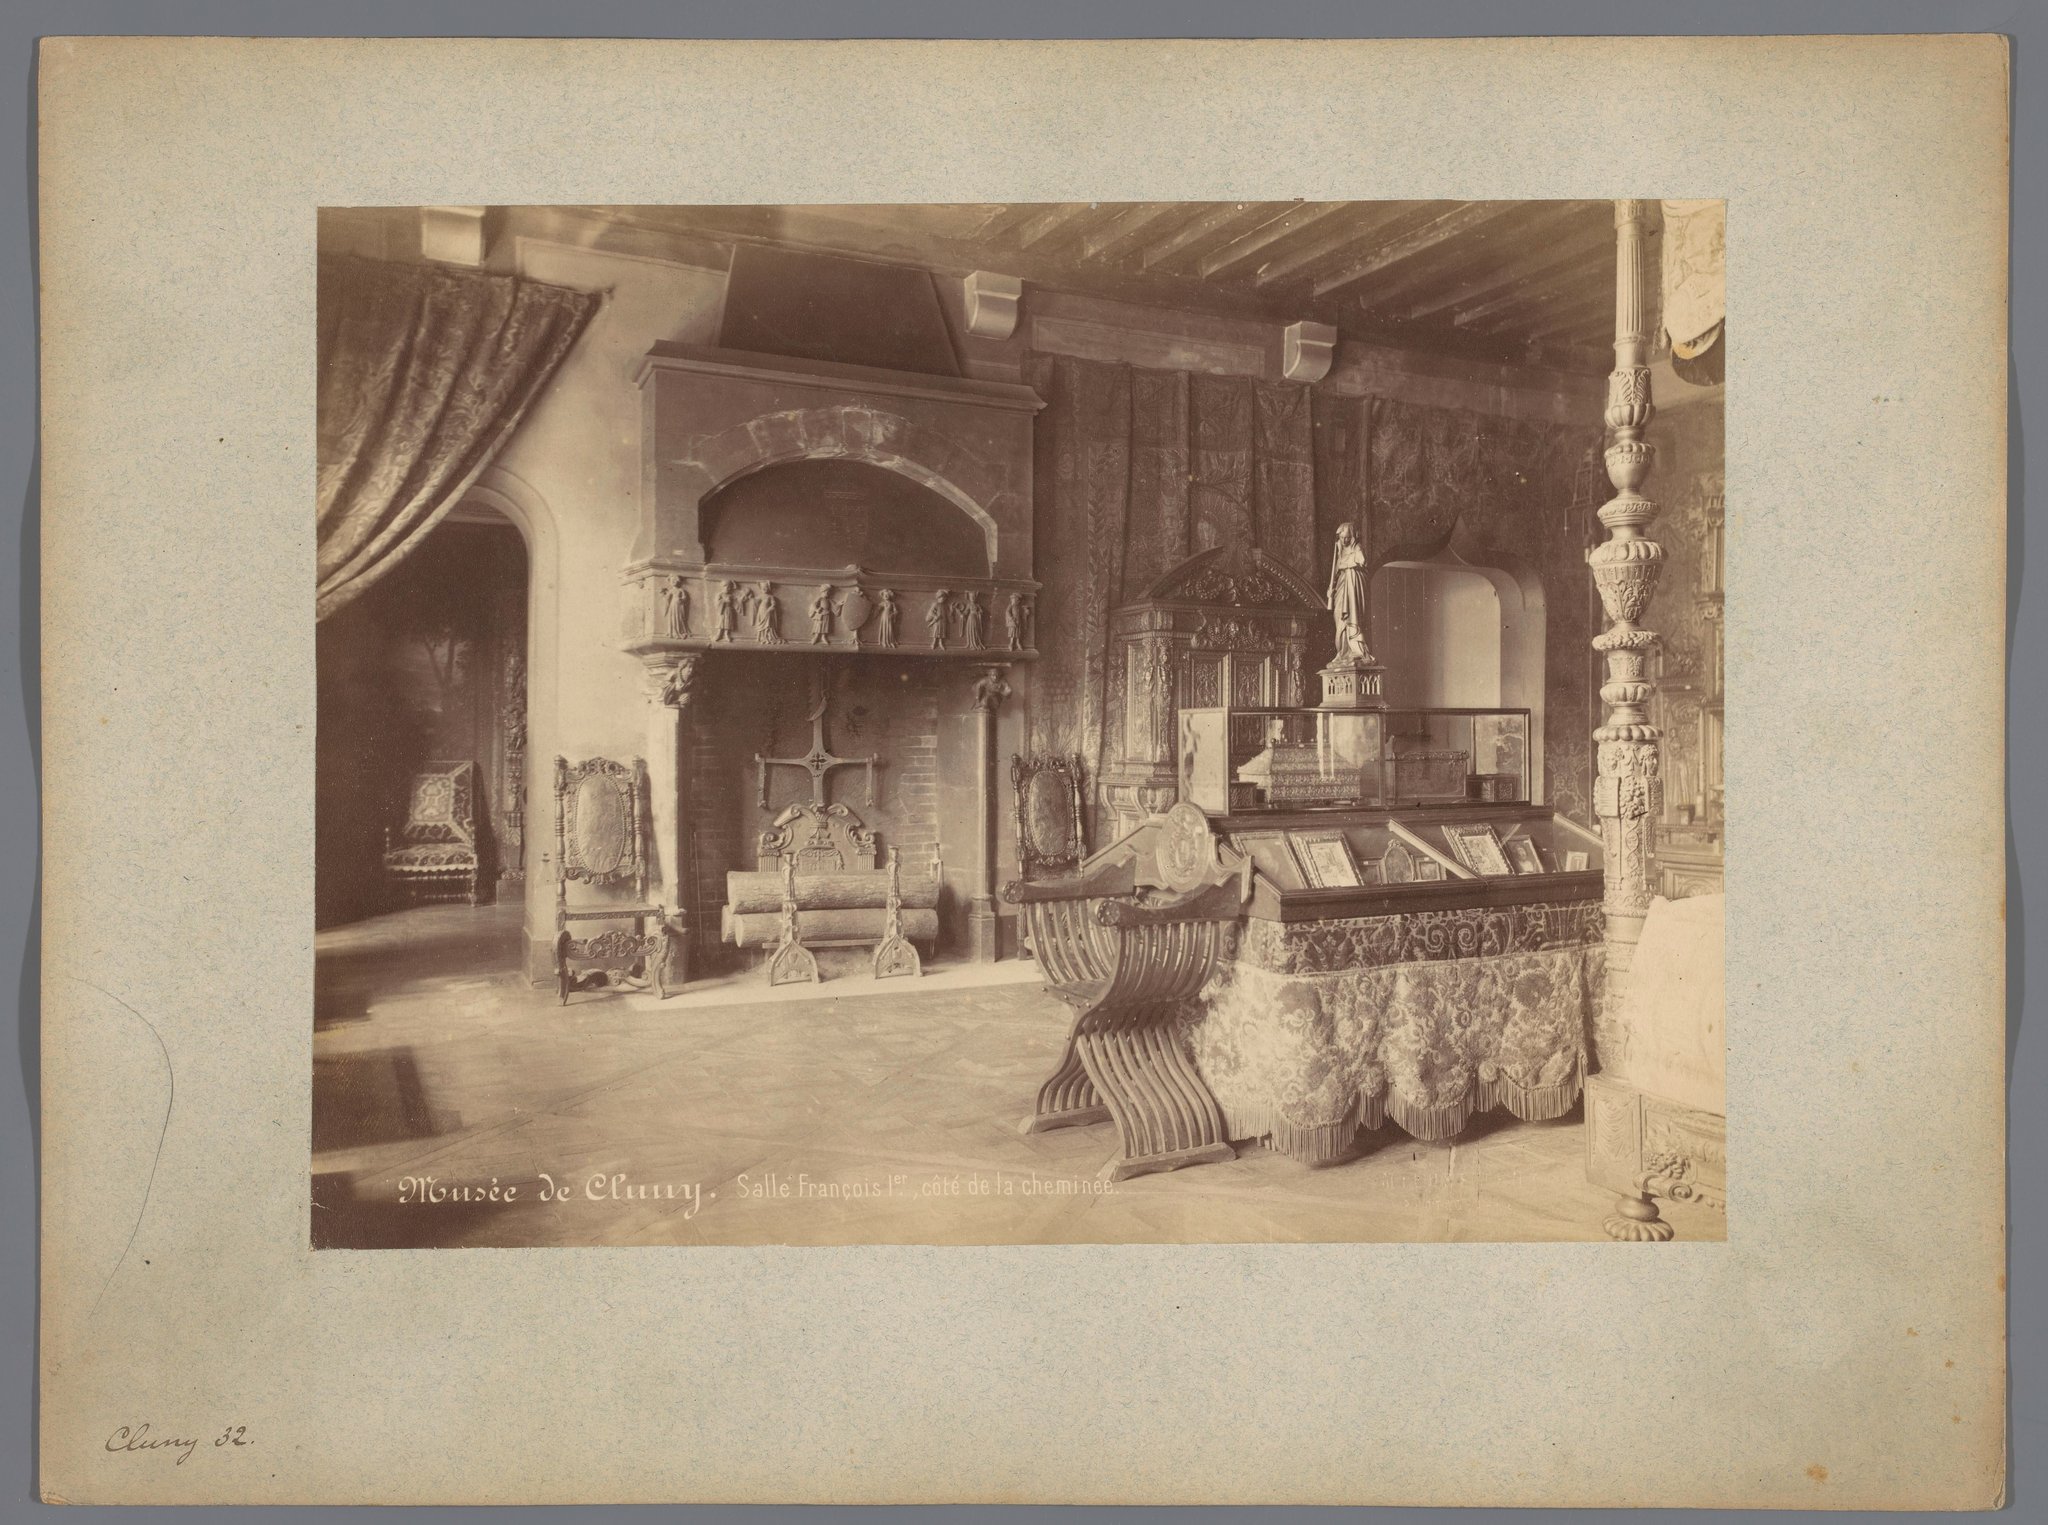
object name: photograph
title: Salle François Ier, côte de la chiminée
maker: séraphin-médéric mieusement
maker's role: fotograaf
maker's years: 1840-1905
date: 1850-1900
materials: cardboard, photographic support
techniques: albumen print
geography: paris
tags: permanent exhibition, museum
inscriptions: workshop stamp: ‘Mieusement/ Photographe’, number: ‘Cluny 32’, collector's mark: ‘Rijks-normaalschool voor teekenonderwijzers Amsterdam’ Lugt 3937